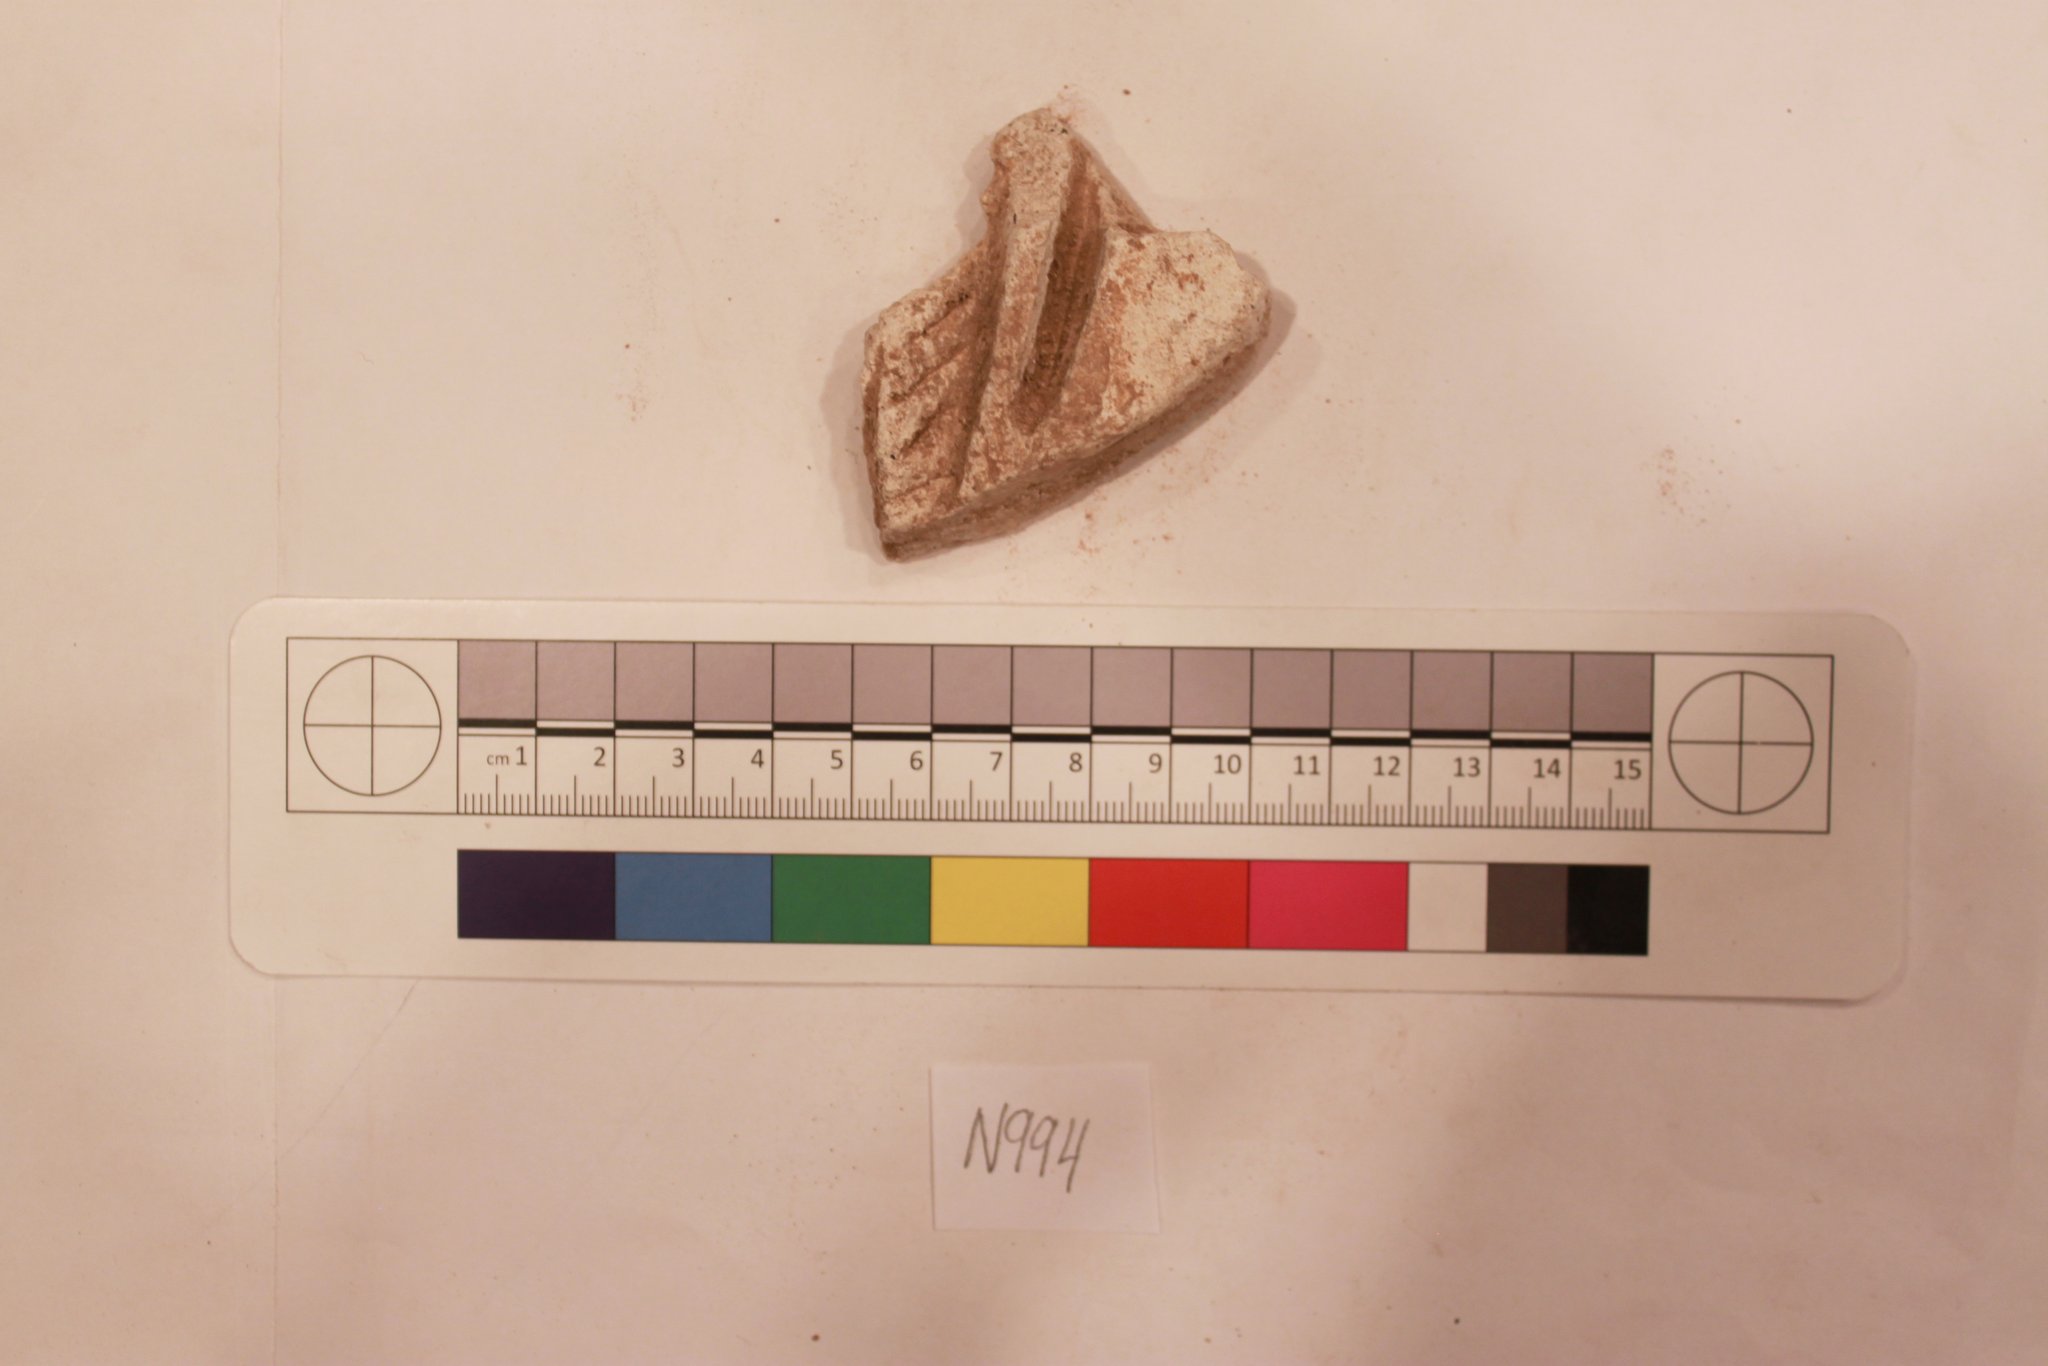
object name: fragment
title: Stucco Fragment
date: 701-1200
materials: plaster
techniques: carving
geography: iran